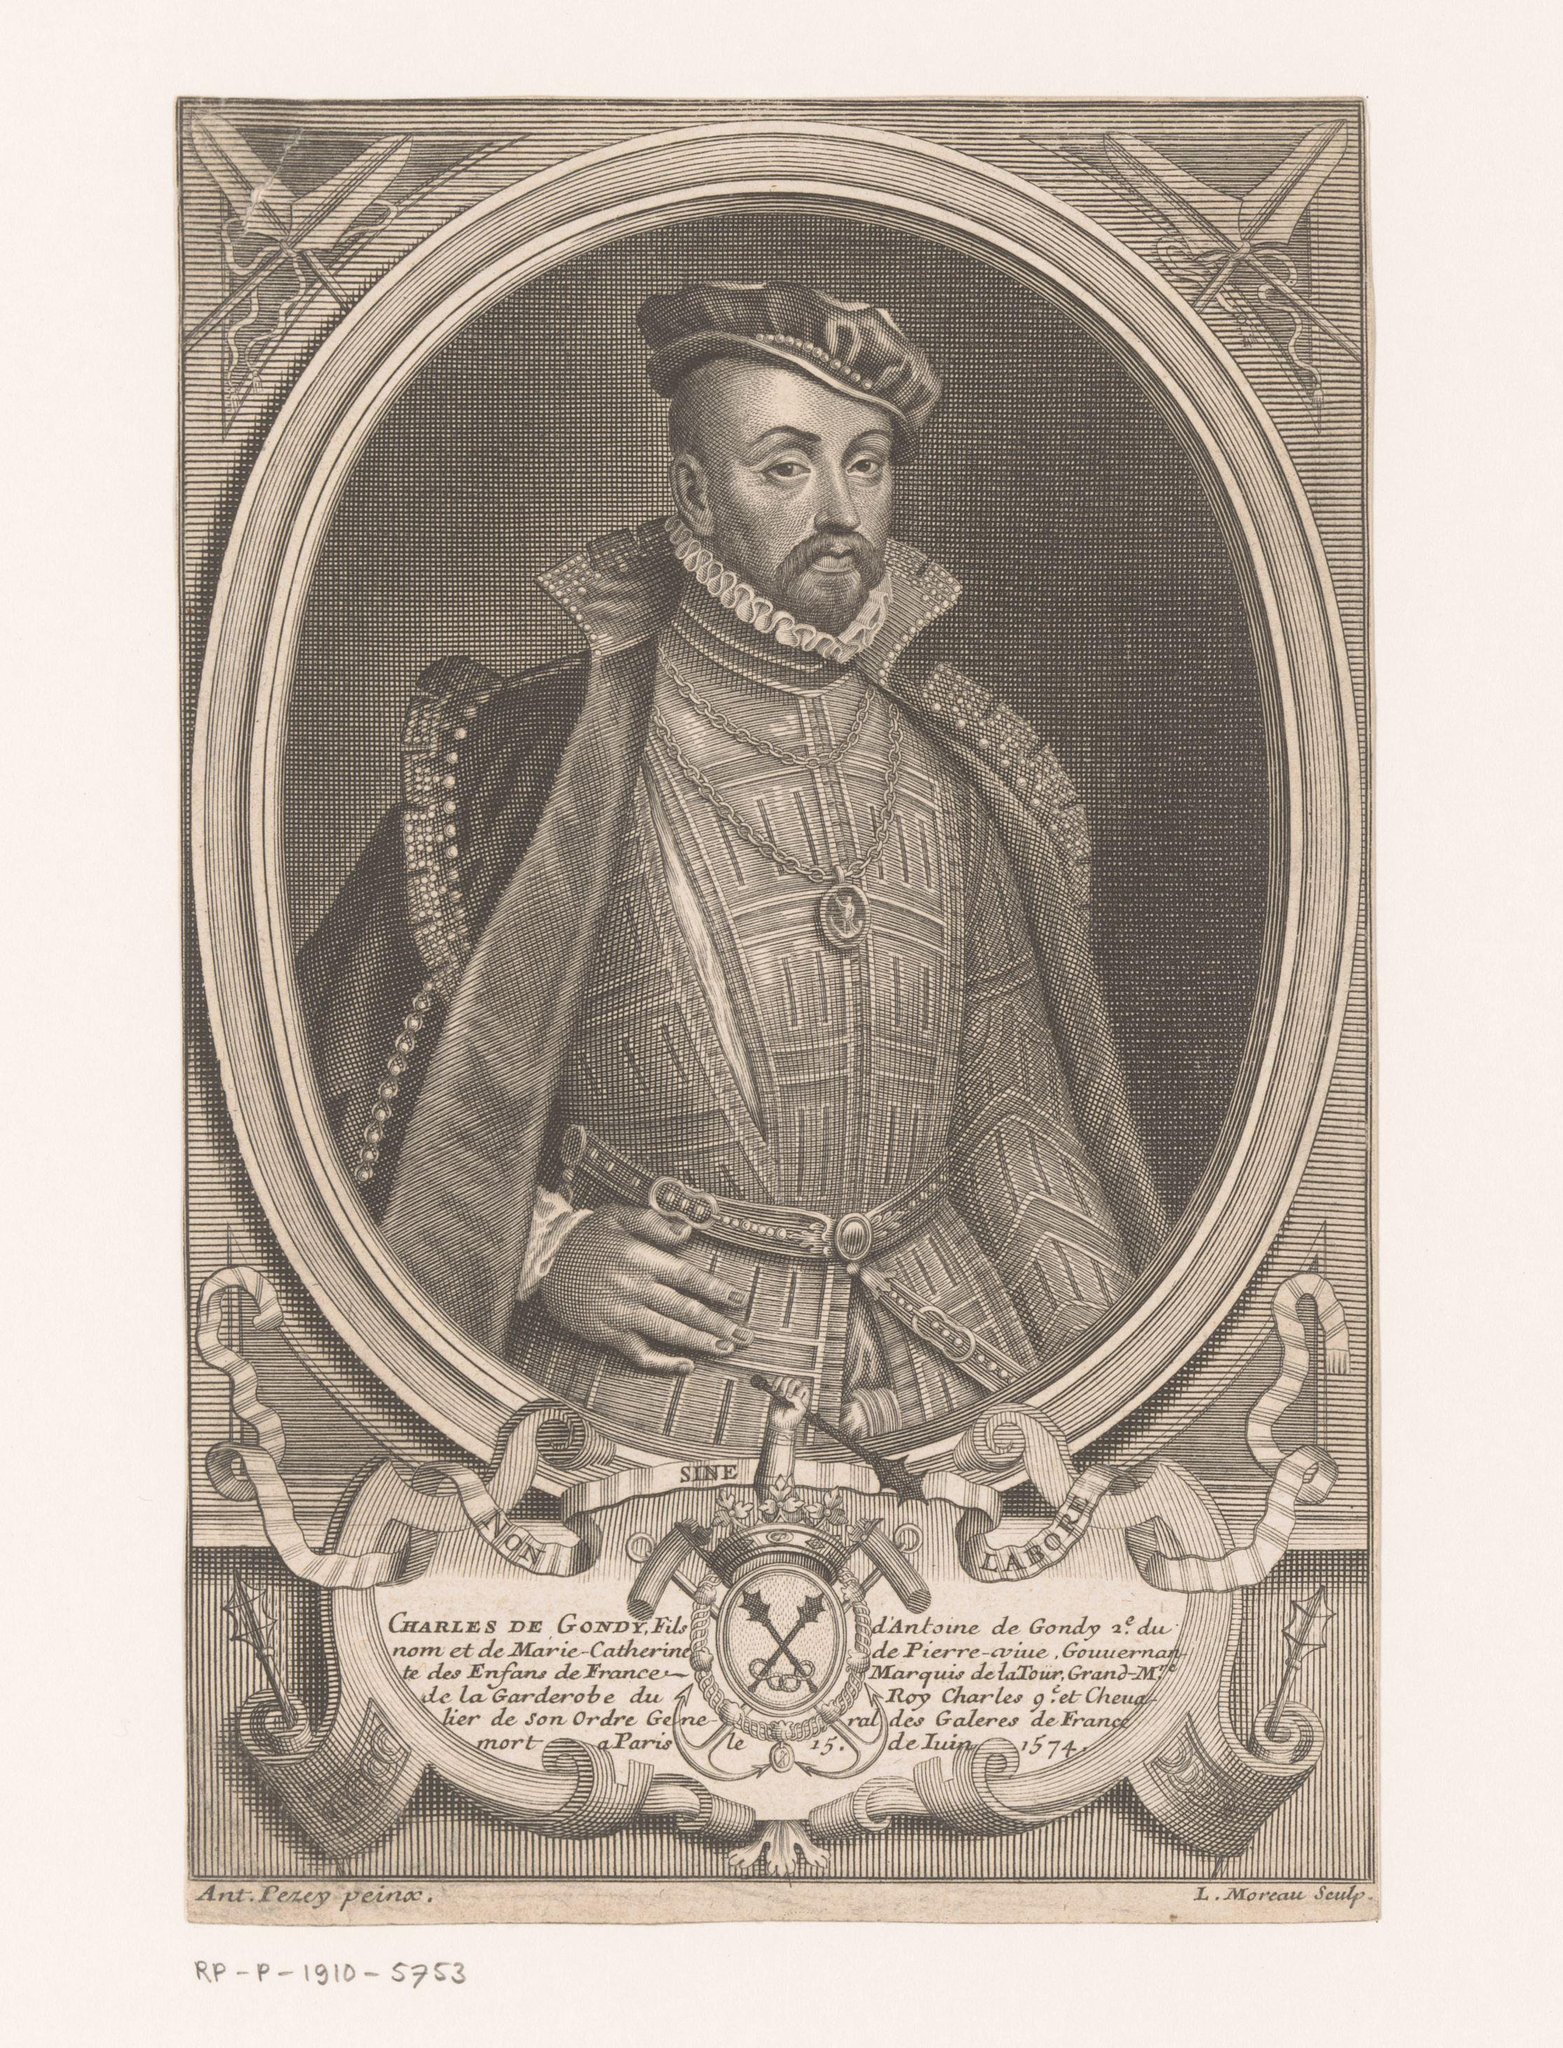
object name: print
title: Portret van Charles de Gondi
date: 1722-1800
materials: paper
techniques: engraving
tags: historical persons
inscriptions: collector's mark: Lugt 2228, inscription: ‘No 2657 2116’